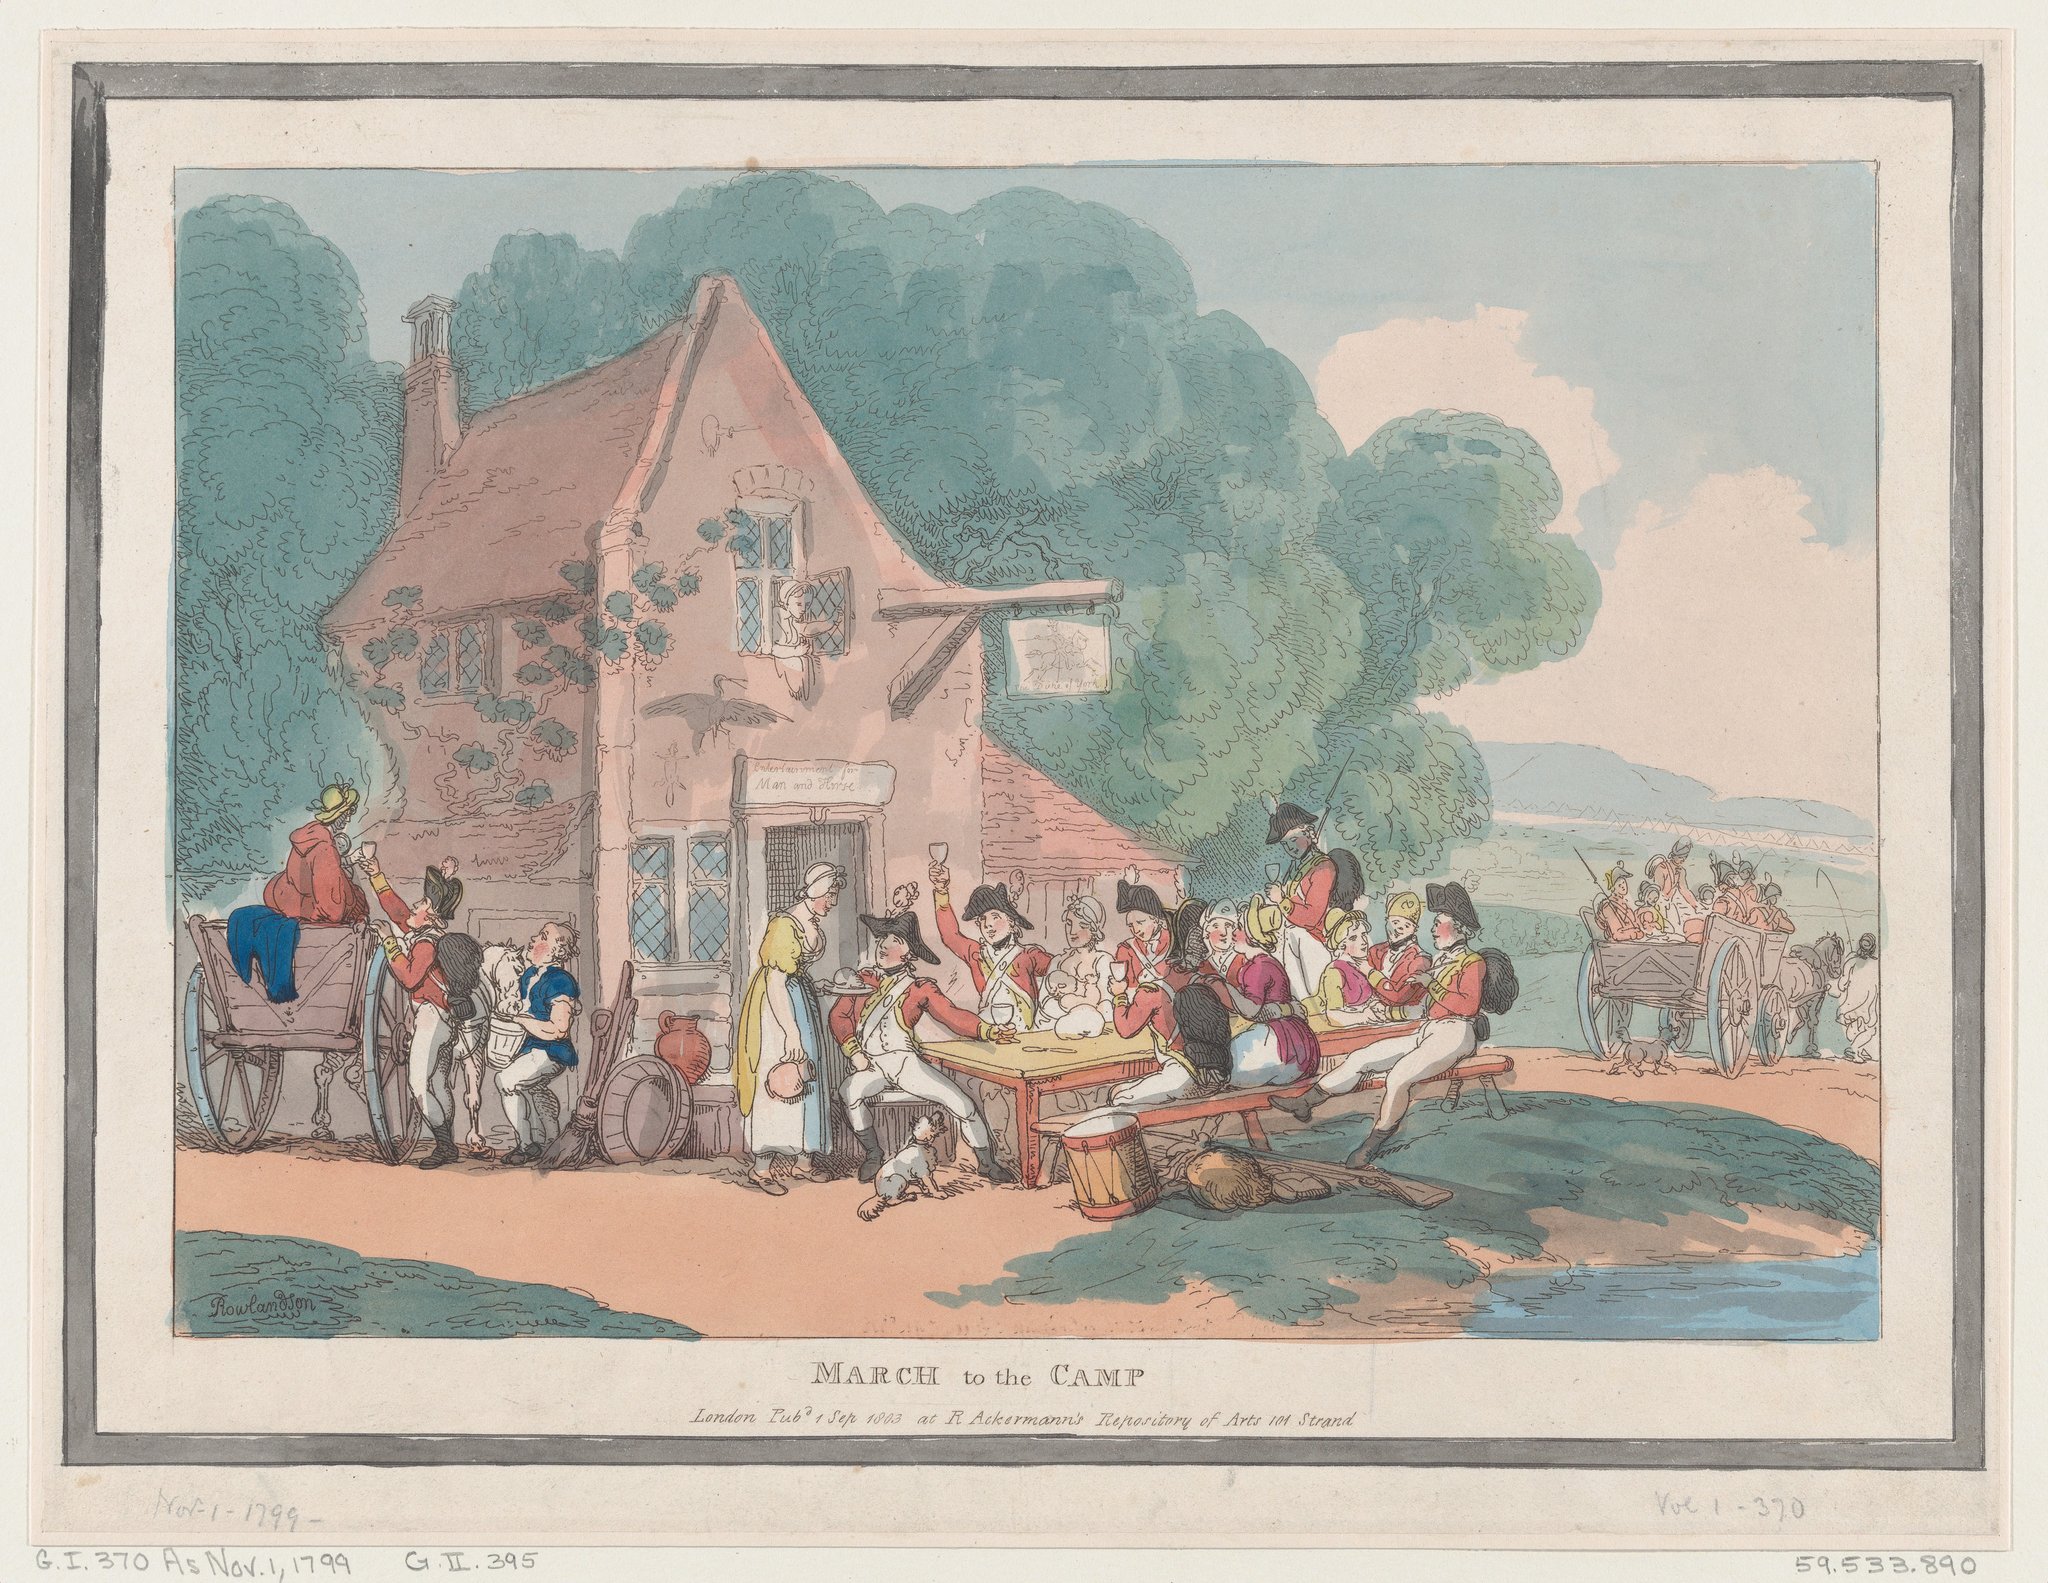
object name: print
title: March to the Camp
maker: thomas rowlandson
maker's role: artist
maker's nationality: british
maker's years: 1757-1827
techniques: etching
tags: soldiers,men,women,drinking